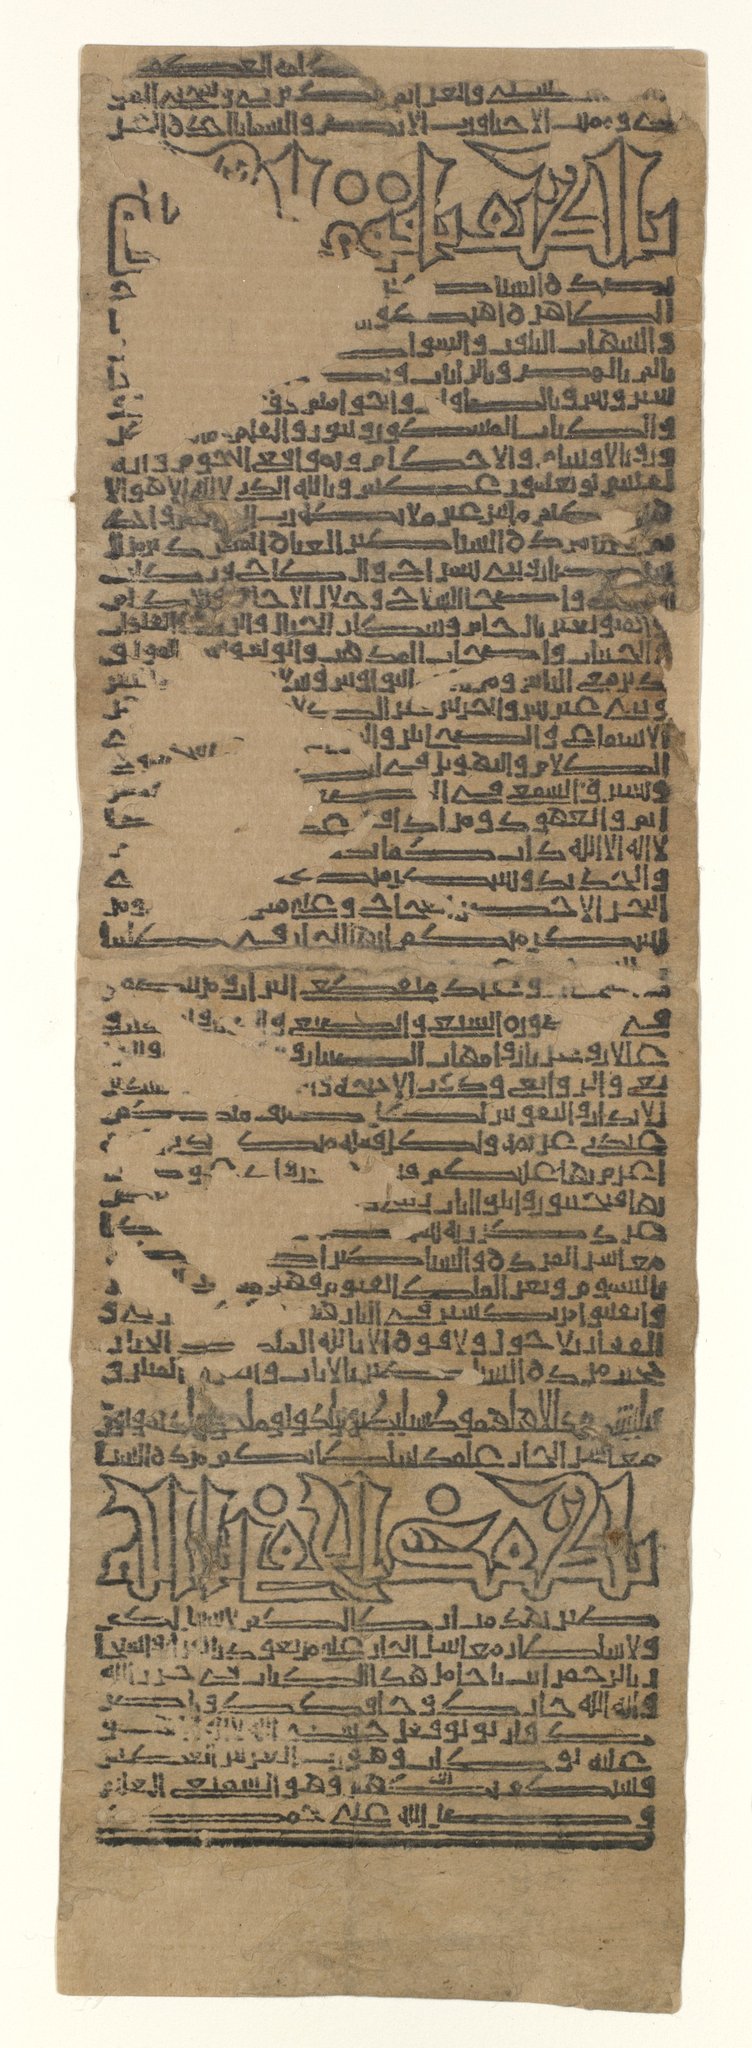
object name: scroll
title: Talismanic Scroll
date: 1001-1100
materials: ink, paper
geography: egypt